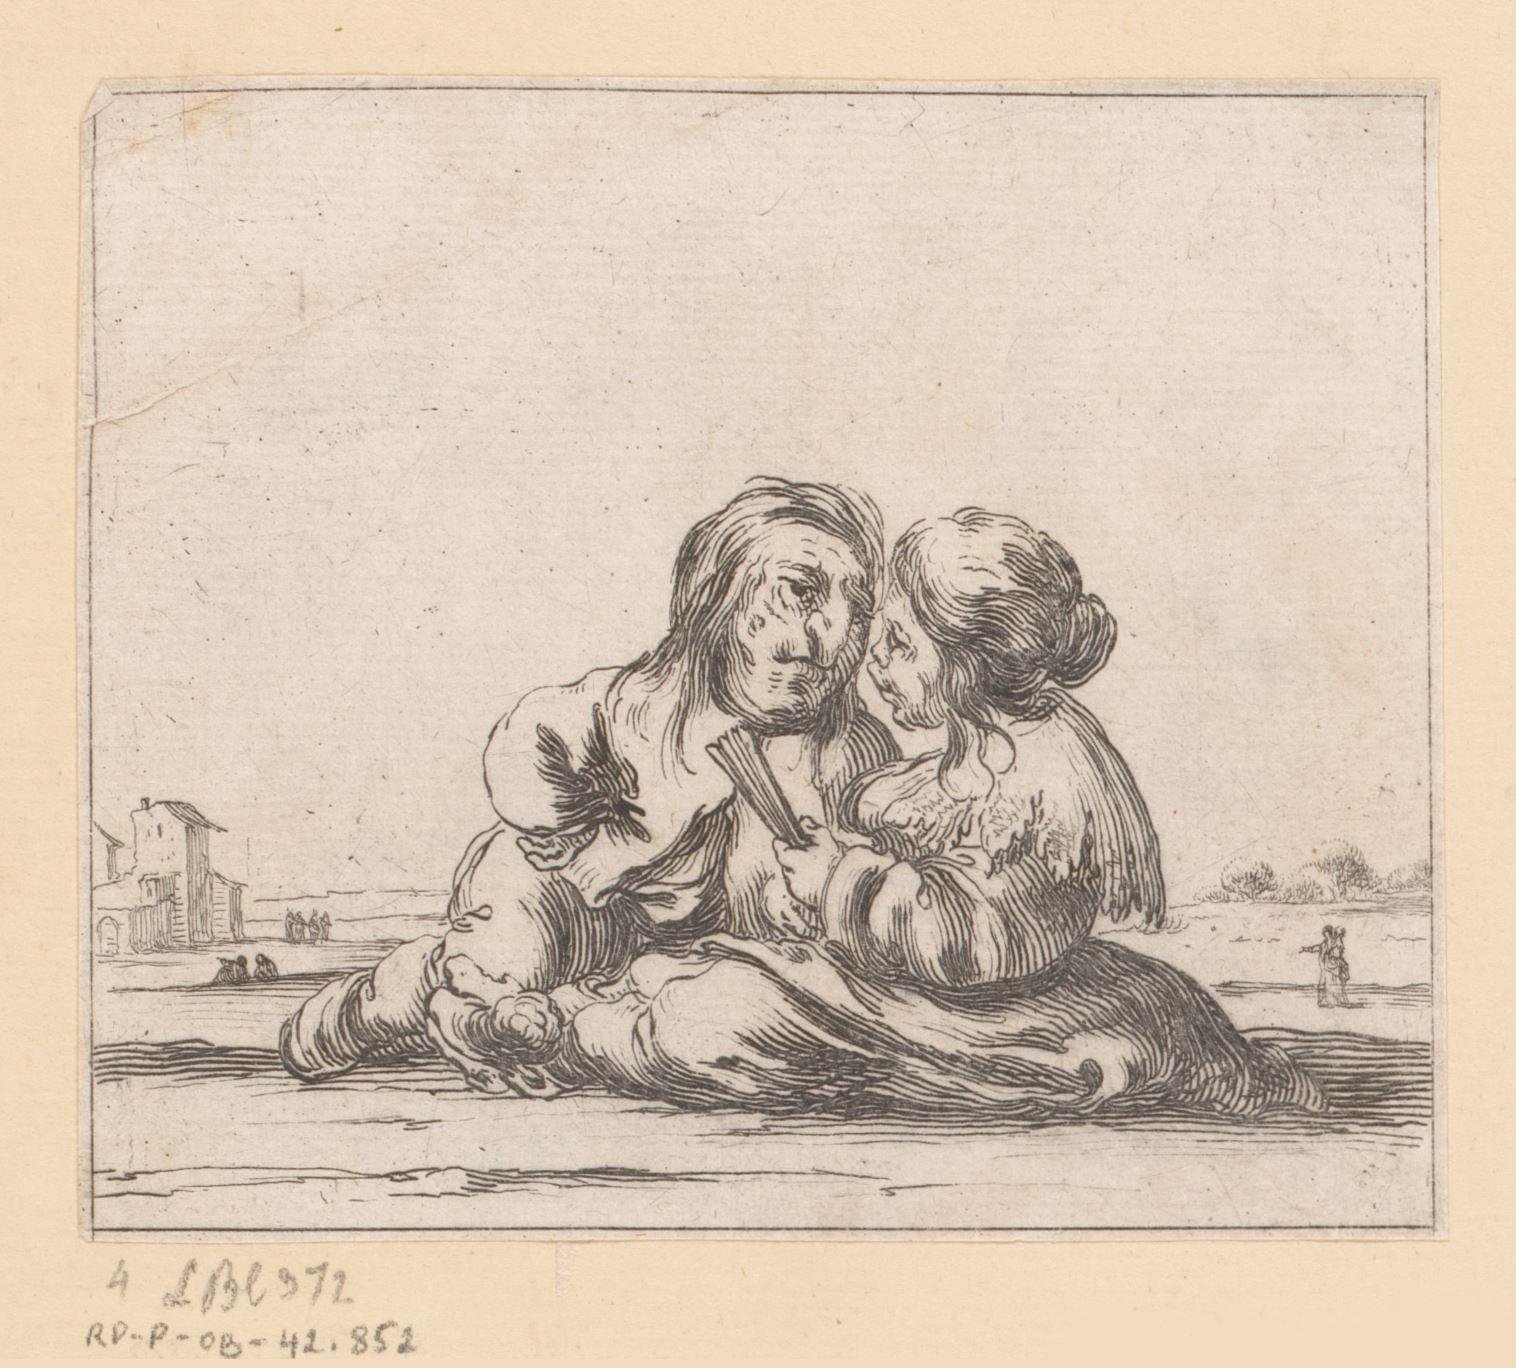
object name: print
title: Karikatuur van een rustend koppel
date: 1620-1687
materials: paper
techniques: etching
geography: italy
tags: adult woman, caricatures (human types), adult man, resting - bb - out of doors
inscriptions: collector's mark: Lugt 240